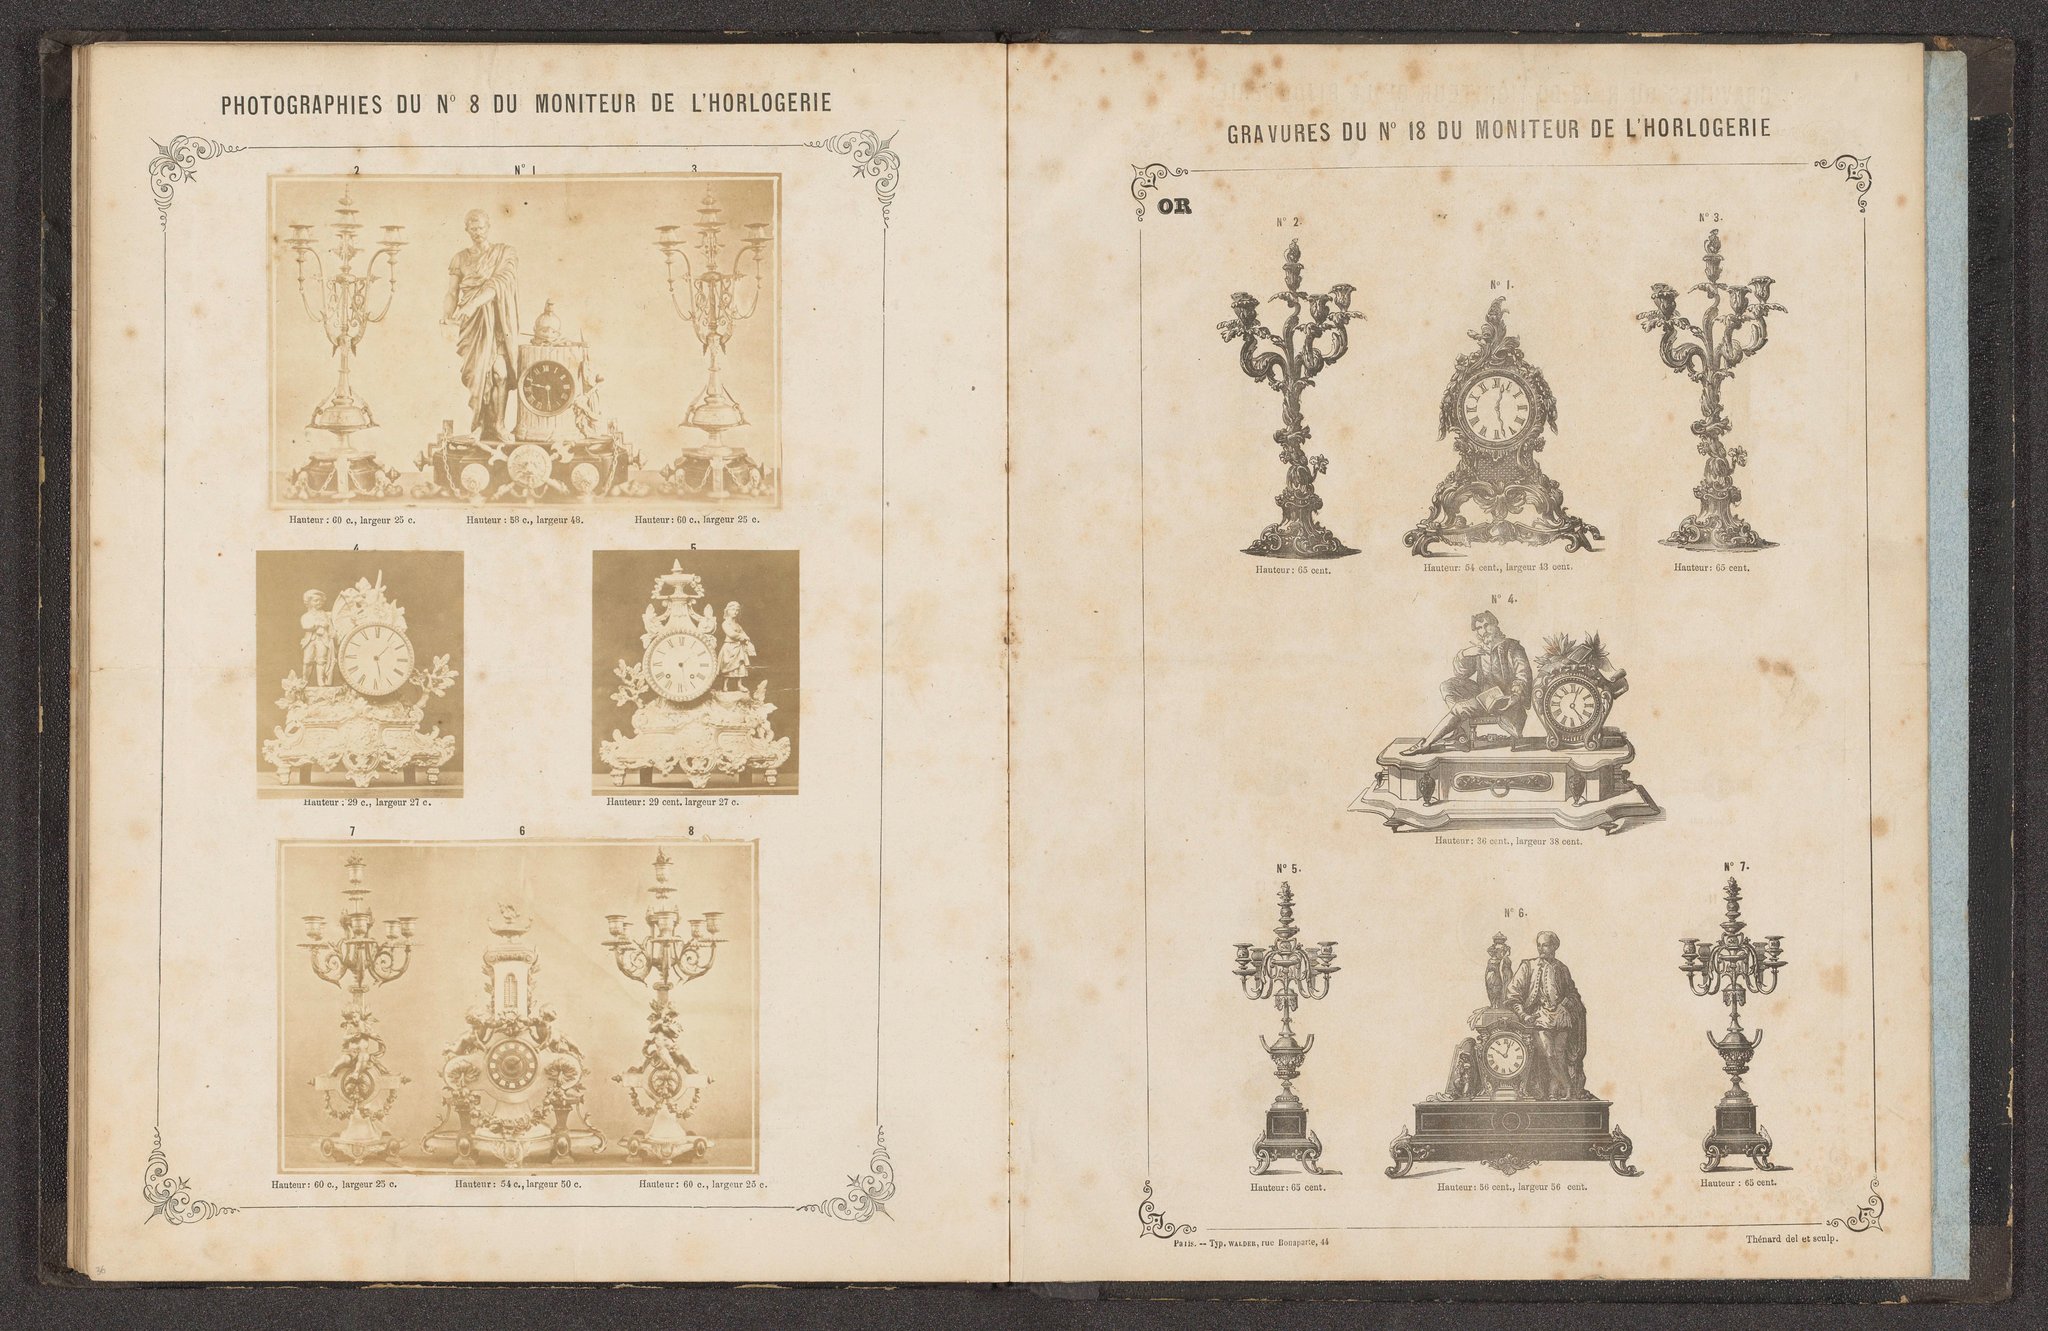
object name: photograph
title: Vier afbeeldingen van klokken en schouwstellen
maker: Anonymous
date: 1857-1867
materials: photographic support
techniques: albumen print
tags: clock, candlestick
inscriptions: number